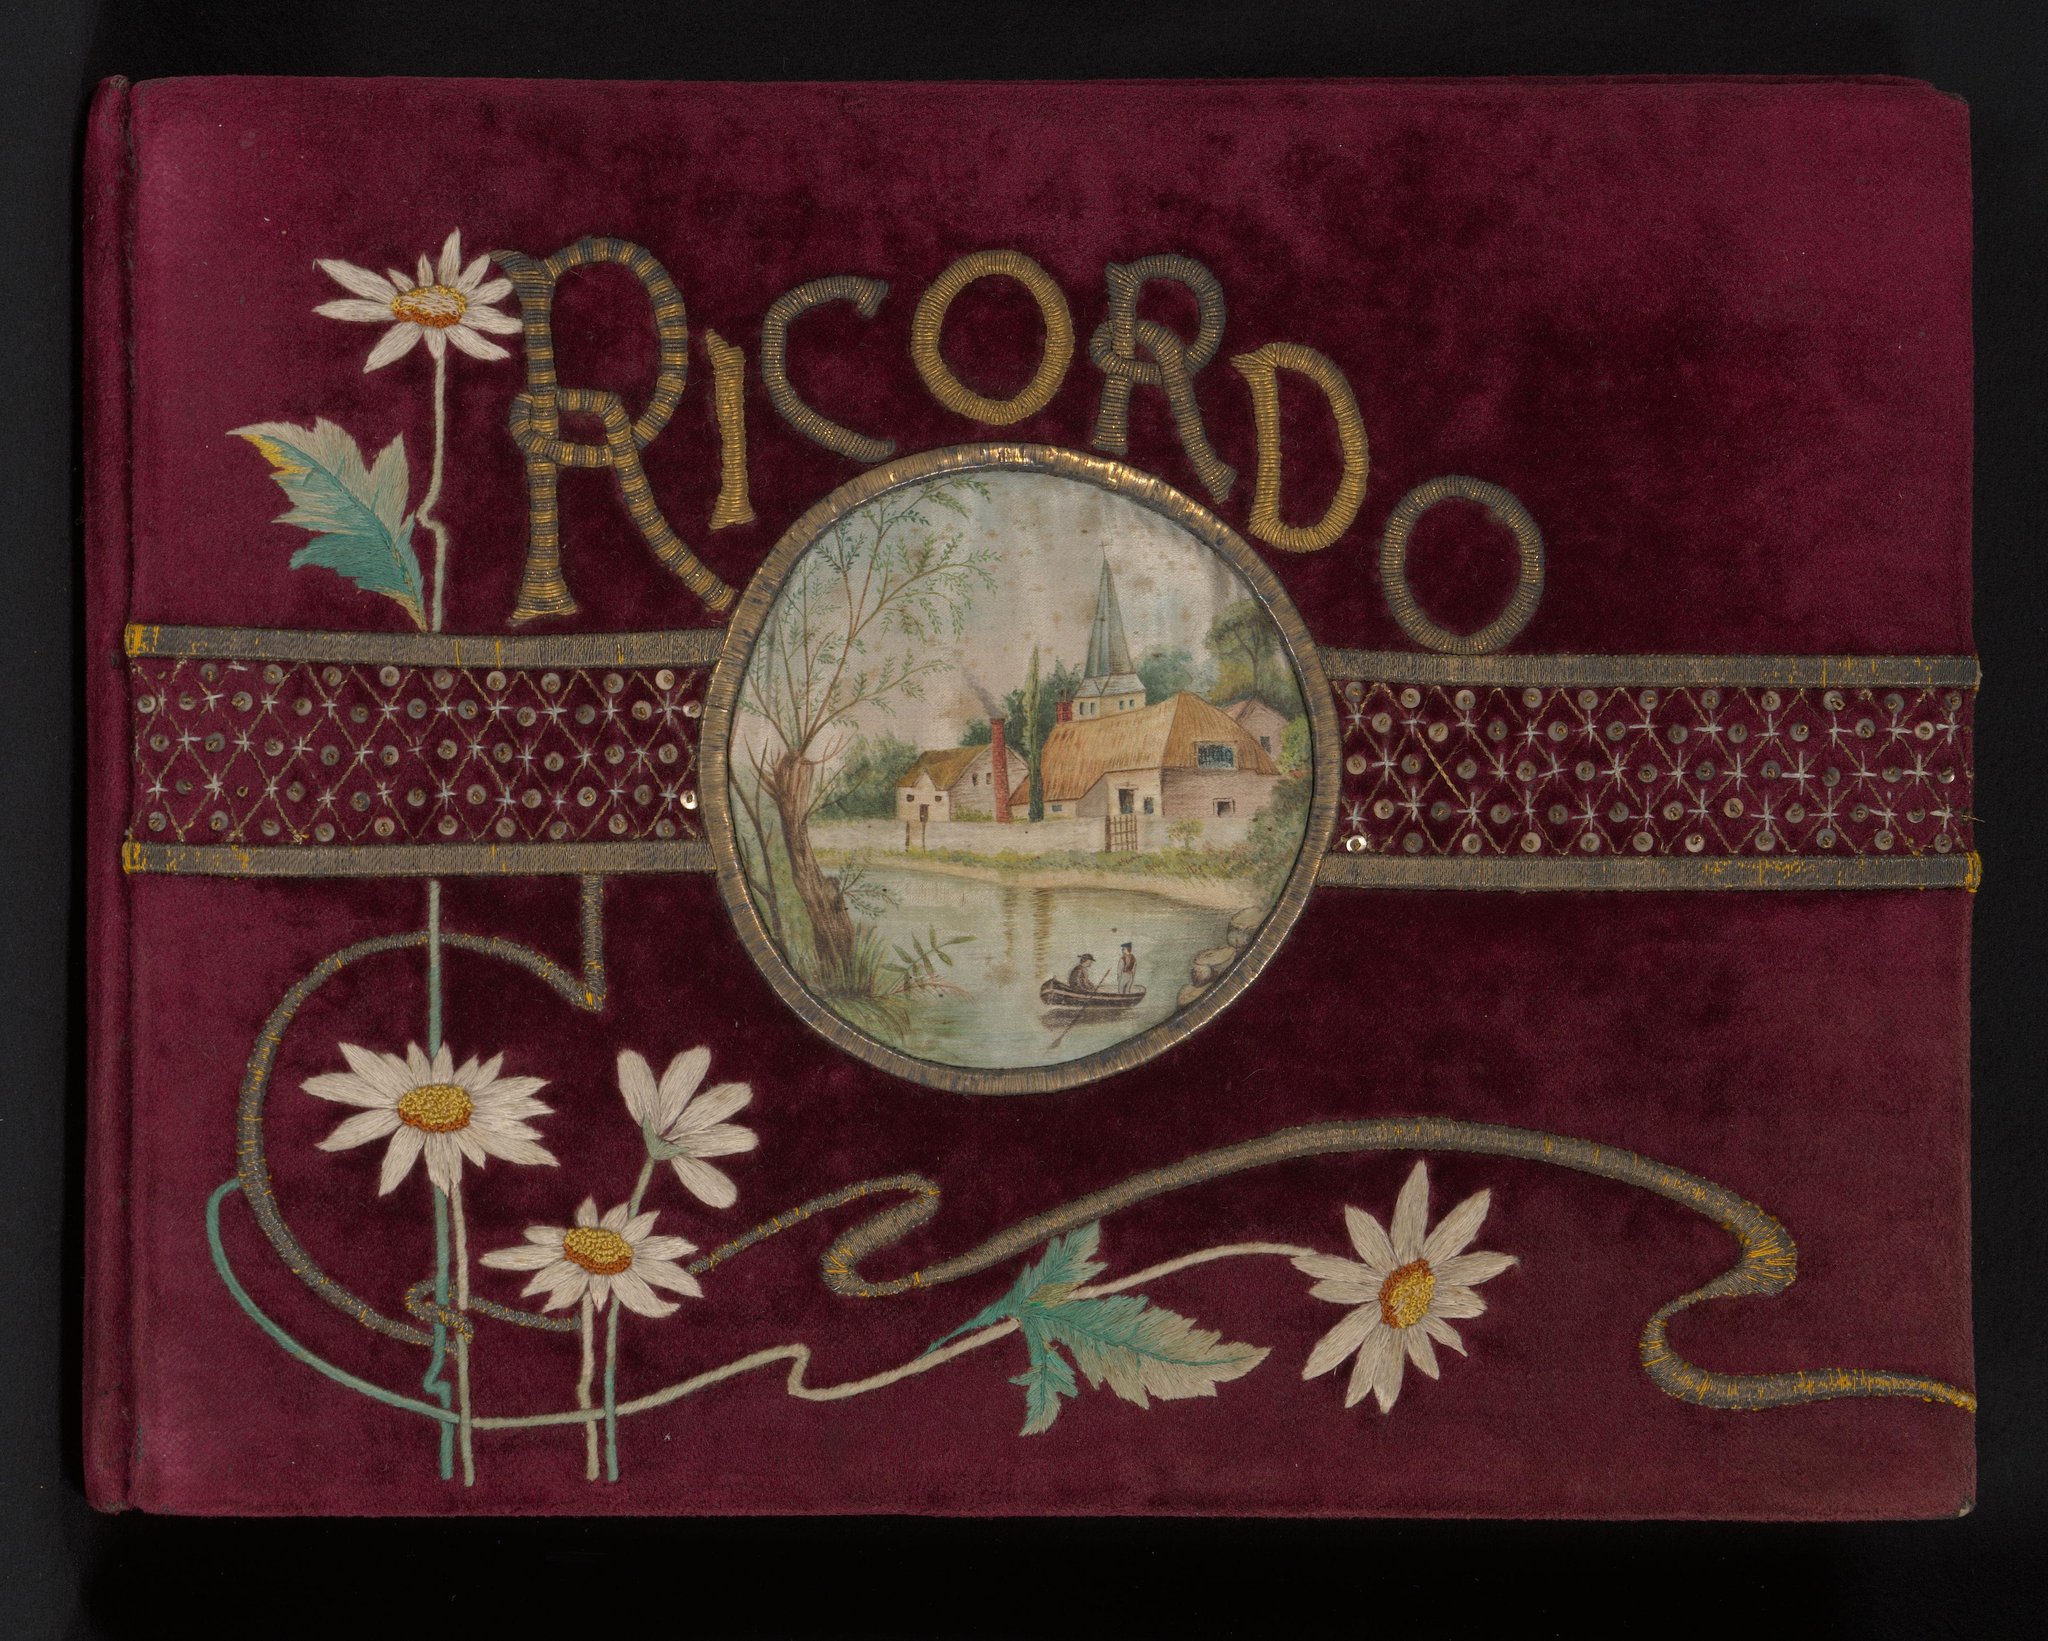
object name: slip in album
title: Fotoalbum (leeg)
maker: Anonymous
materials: cardboard, paper, textile, silk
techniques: printing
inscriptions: number: ‘17.793’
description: Fotoalbum met dertien pagina's bekleed met papier, textiel en zijde, met op recto een gedicht in Engels, Italiaans of Frans en op verso één of twee passe-partouts voor een fotokaart. Op de eerste pagina staat een Chinese tekst. In totaal is er in het album plaats voor acht foto's.